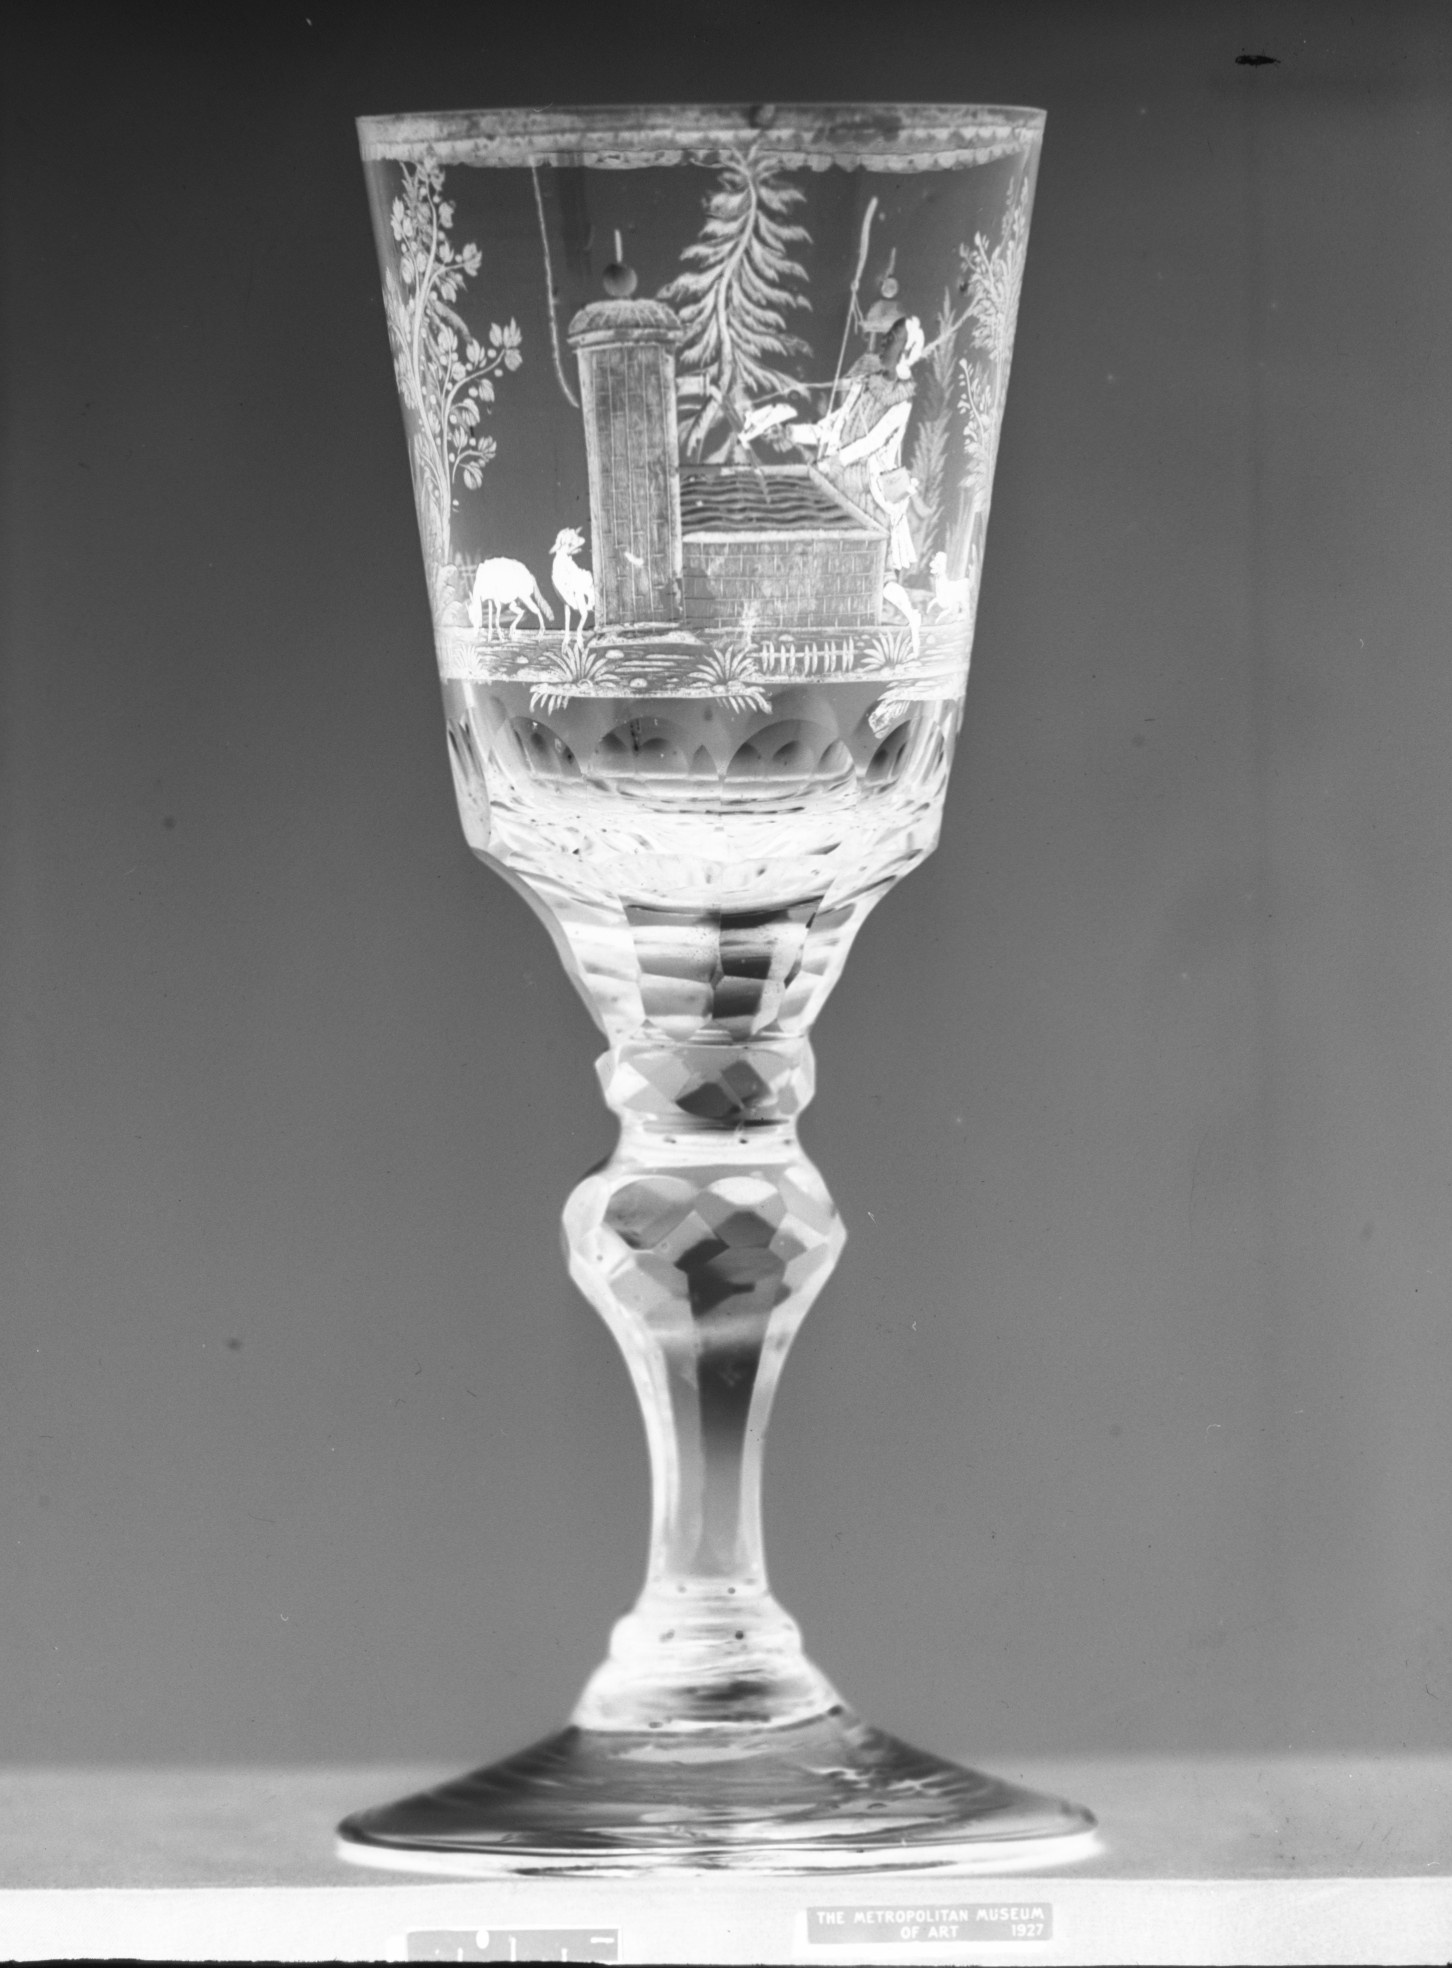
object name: standing cup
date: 1730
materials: glass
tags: human figures,animals,trees